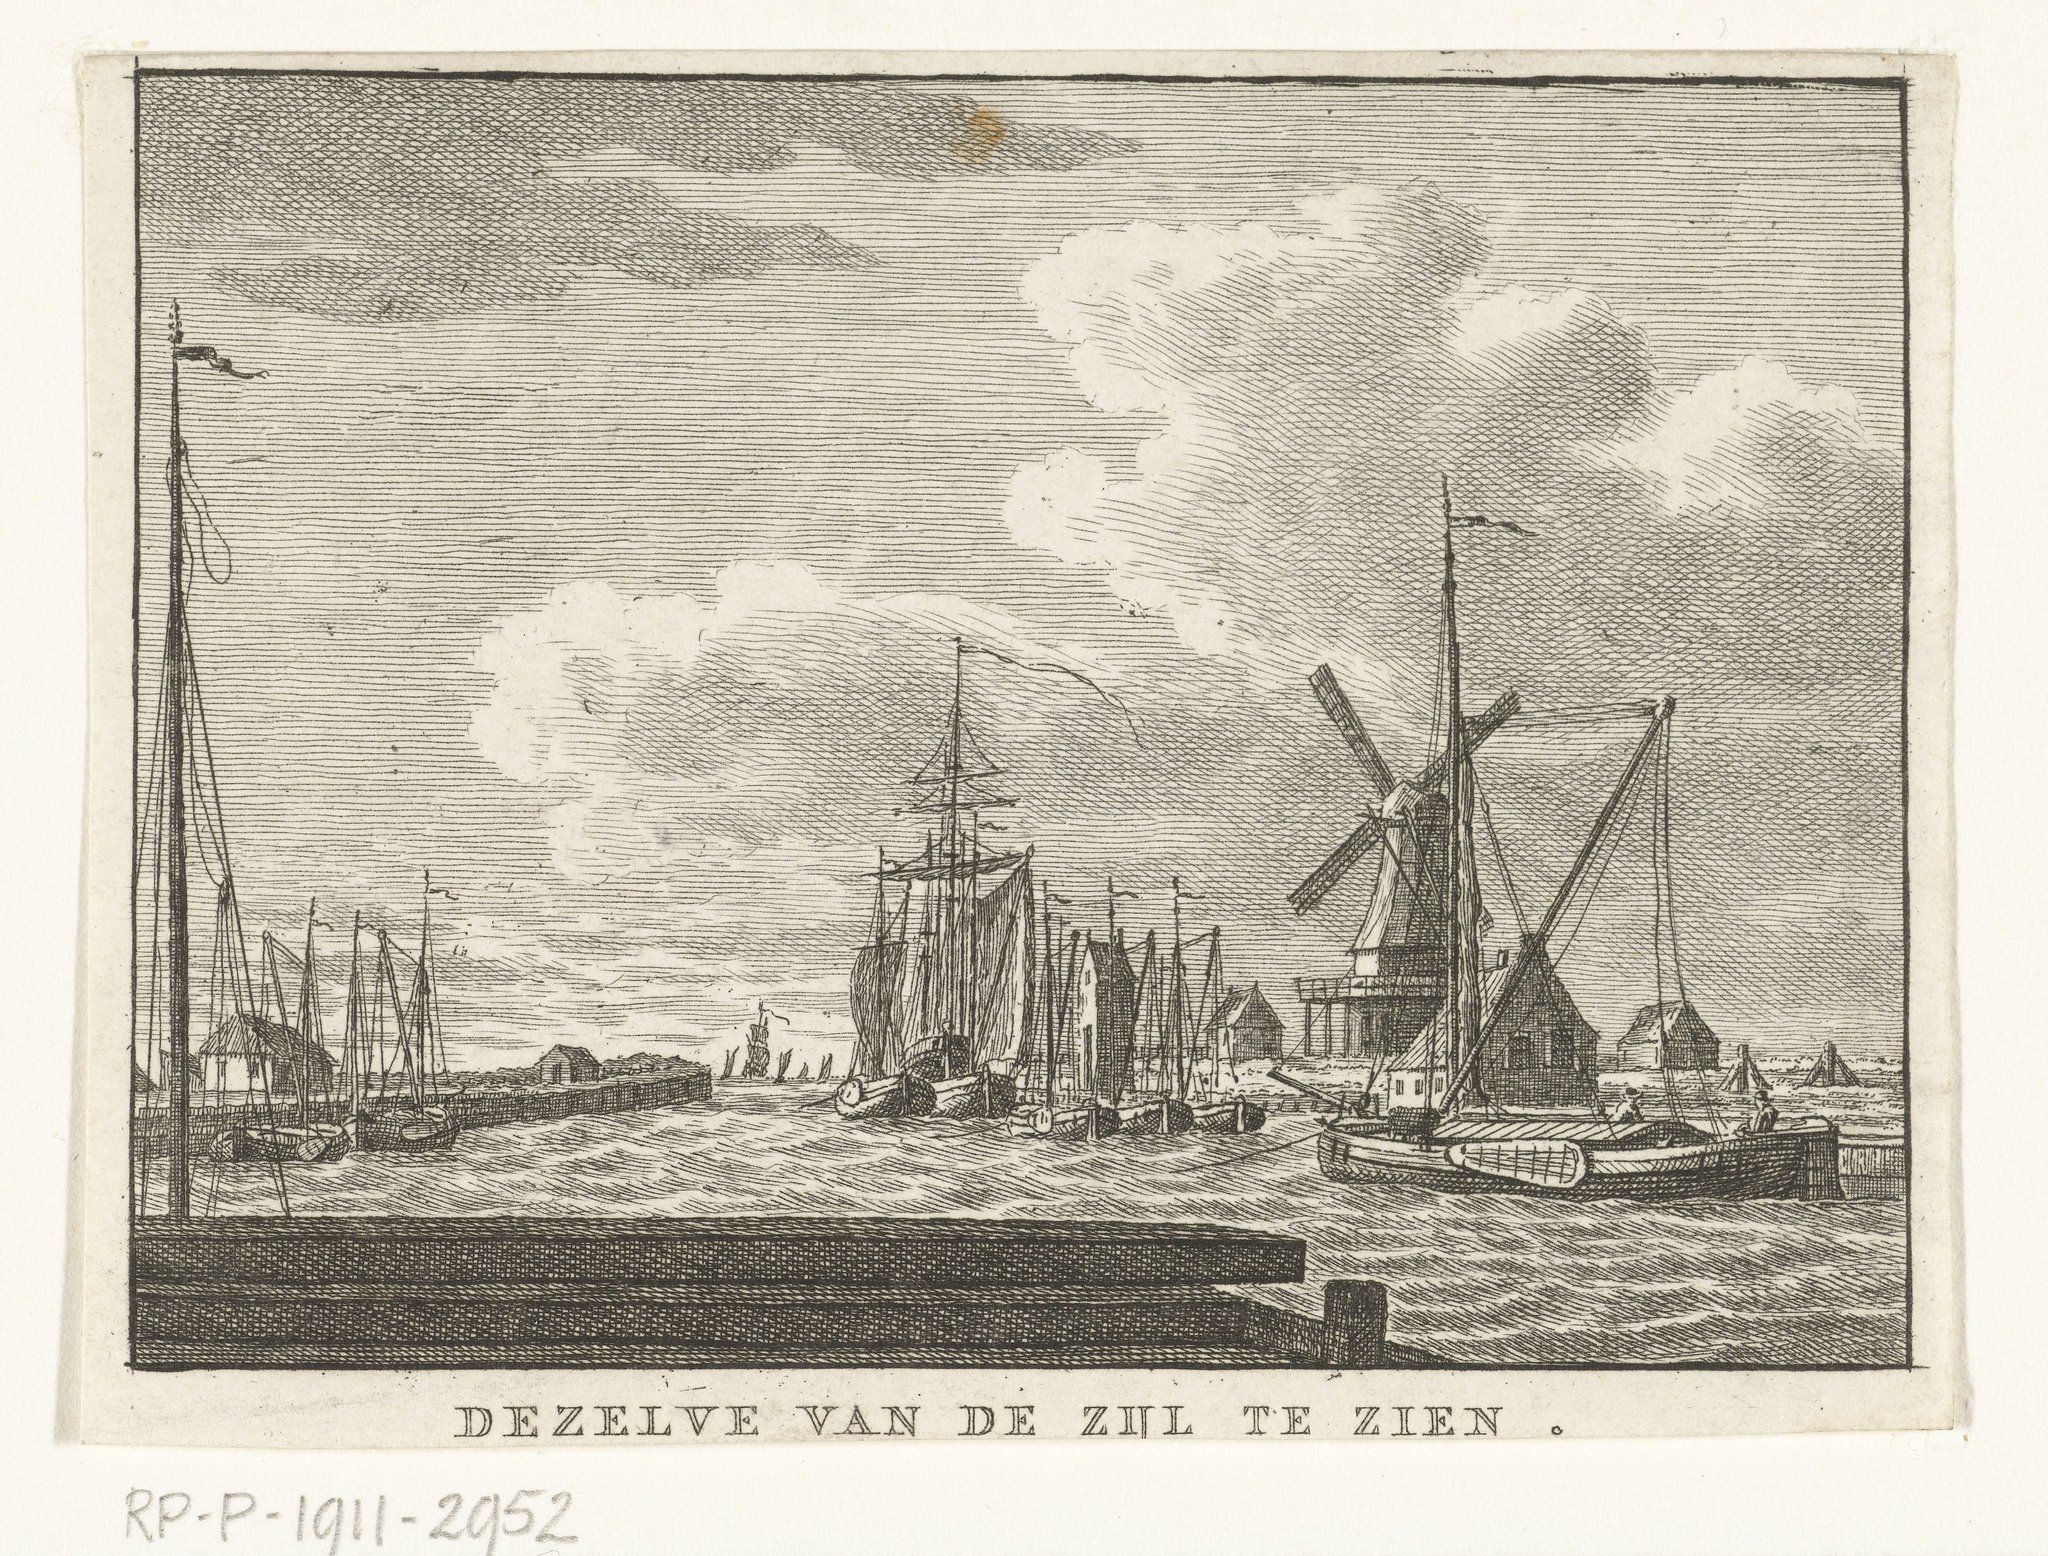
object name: print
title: Haven van Stavoren vanaf sluis de Zijl gezien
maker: carel frederik bendorp (i)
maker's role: print maker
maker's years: 1736-1814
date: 1786-1792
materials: paper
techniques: etching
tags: harbour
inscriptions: collector's mark: Lugt 2228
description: Prent uit: Vaderlandsche gezichten, of afbeeldingen van den tegenwoordigen staat der Vereenigde Nederlanden (…). Amsterdam: Hendrik Gartman, Willem Vermandel en Jan Willem Smit, 1786-1792. Uitgegeven in afleveringen met ieder een eigen bifolium en inhoudsopgave. Alle prenten in deze publicatie zijn gegraveerd door Carel Frederik Bendorp (I) en, in de meeste gevallen, gebaseerd op tekeningen van Jan Bulthuis. Prent losgesneden uit blad met oorspronkelijk twee prenten (zie RP-P-1911-2951).